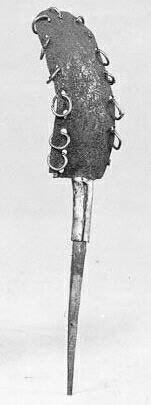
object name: rattle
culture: ethiopian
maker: taga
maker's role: maker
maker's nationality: ethiopian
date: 1867-1900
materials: tin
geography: ethiopia